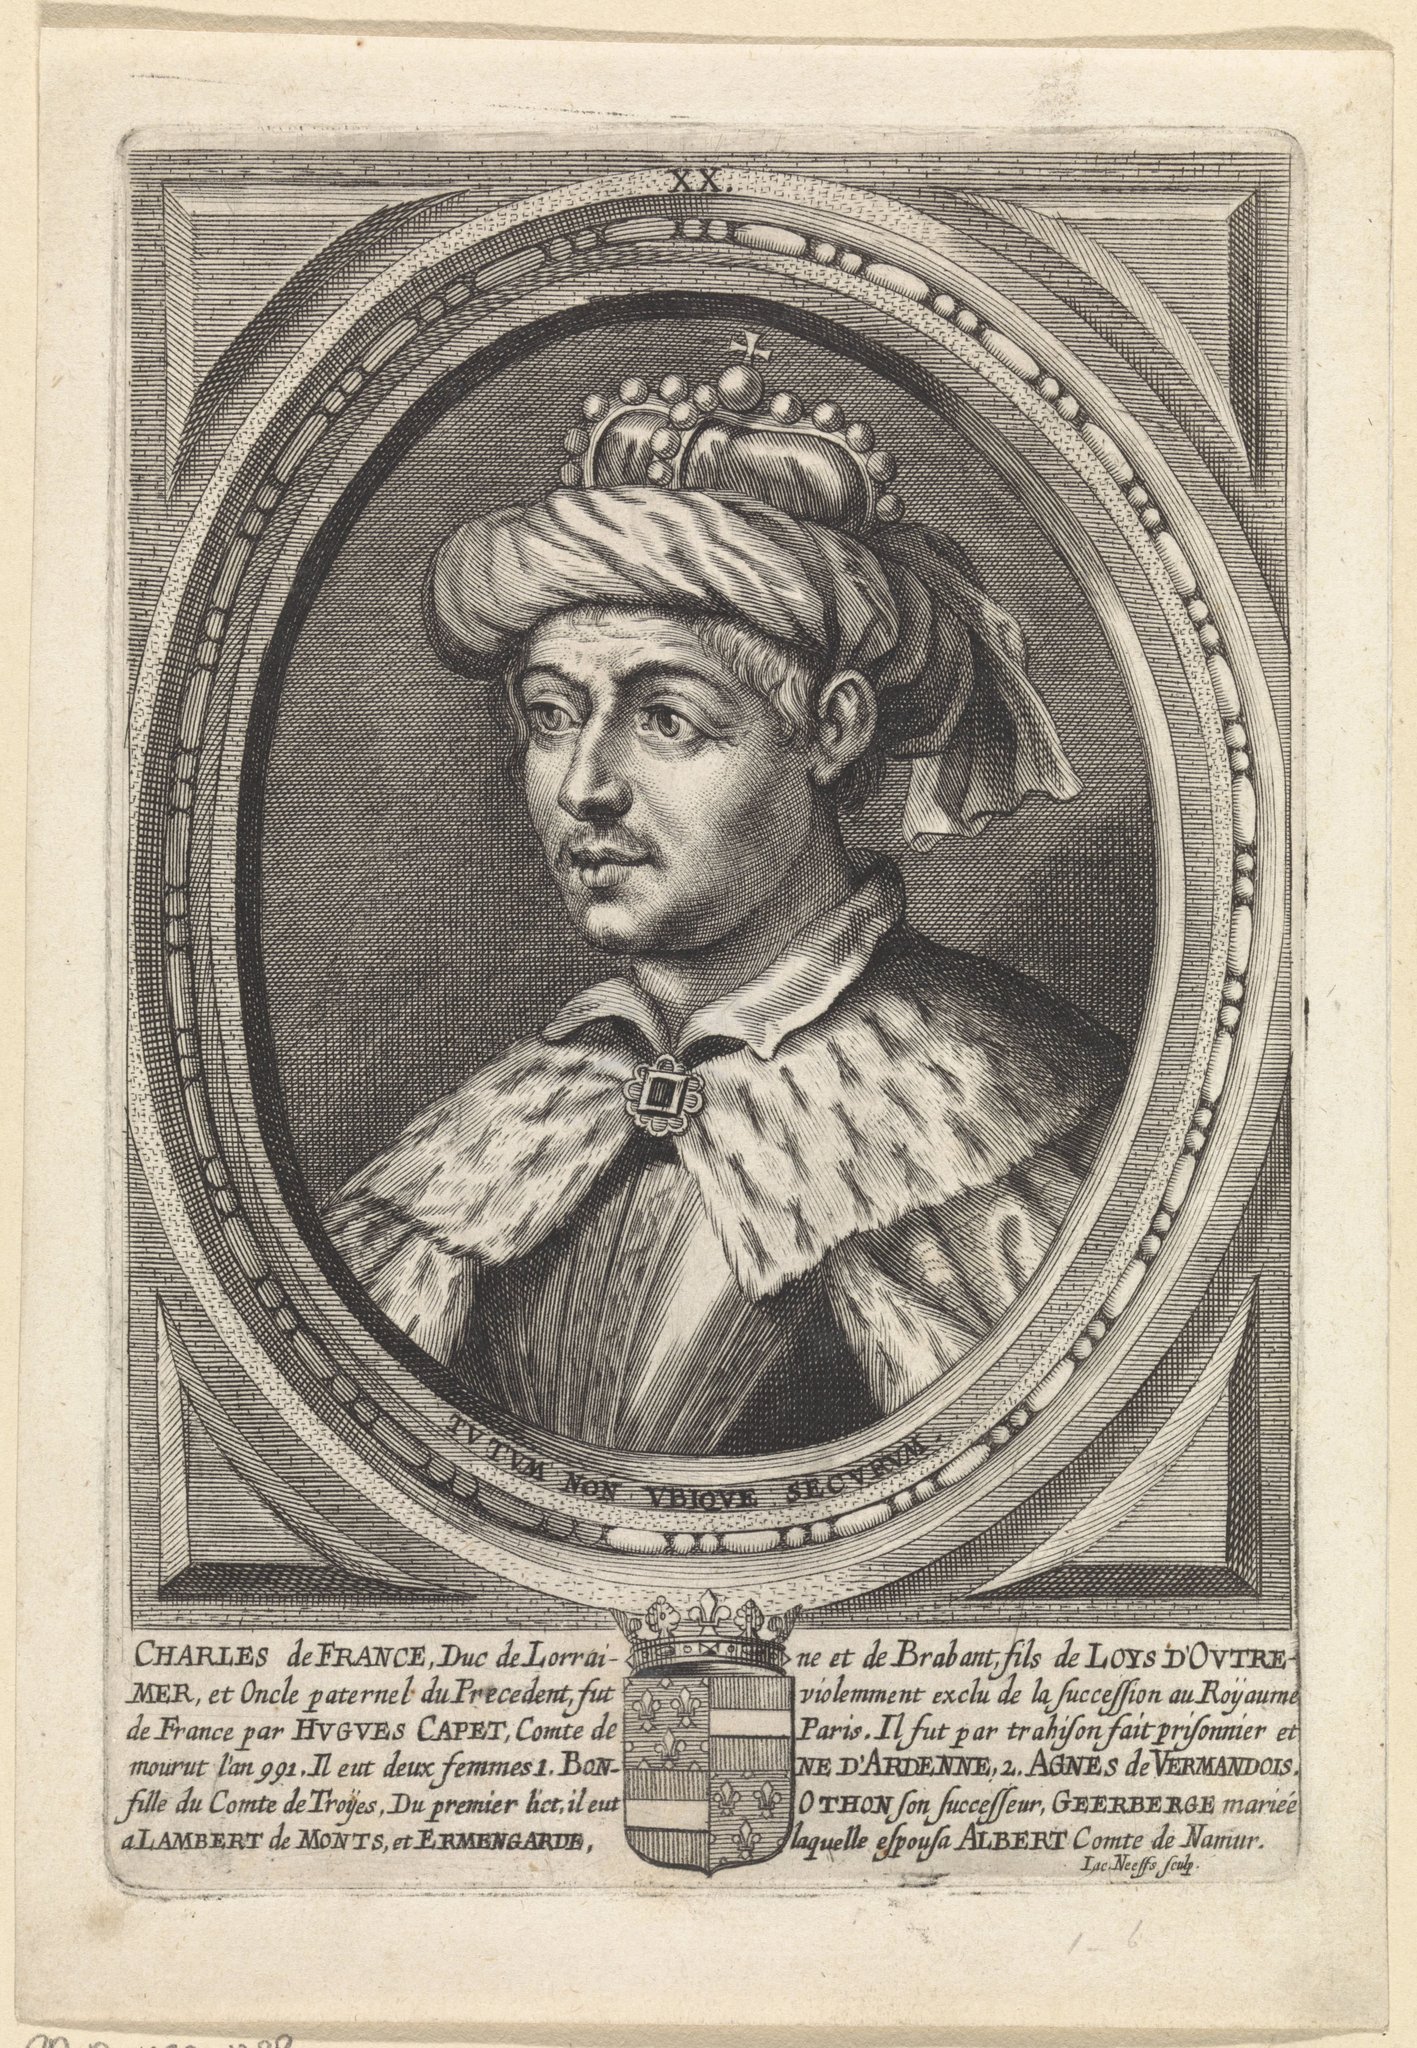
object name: print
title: Portret van hertog Karel van Neder-Lotharingen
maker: jacob neefs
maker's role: print maker, publisher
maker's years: 1610-1660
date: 1620-1680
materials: paper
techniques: engraving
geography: antwerp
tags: orléans, hertog, karel (hertog van neder-lotharingen)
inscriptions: collector's mark: Lugt 2228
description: Hertog Karel van Neder-Lotharingen, gekleed in harnas en hermelijnen mantel, draagt een tulband met een kroon op het hoofd. Buste naar links in een ovaal. Onderaan in de marge zijn wapen en twee kolommen van zes regels in het Frans. Midden boven op de lijst genummerd: XX.